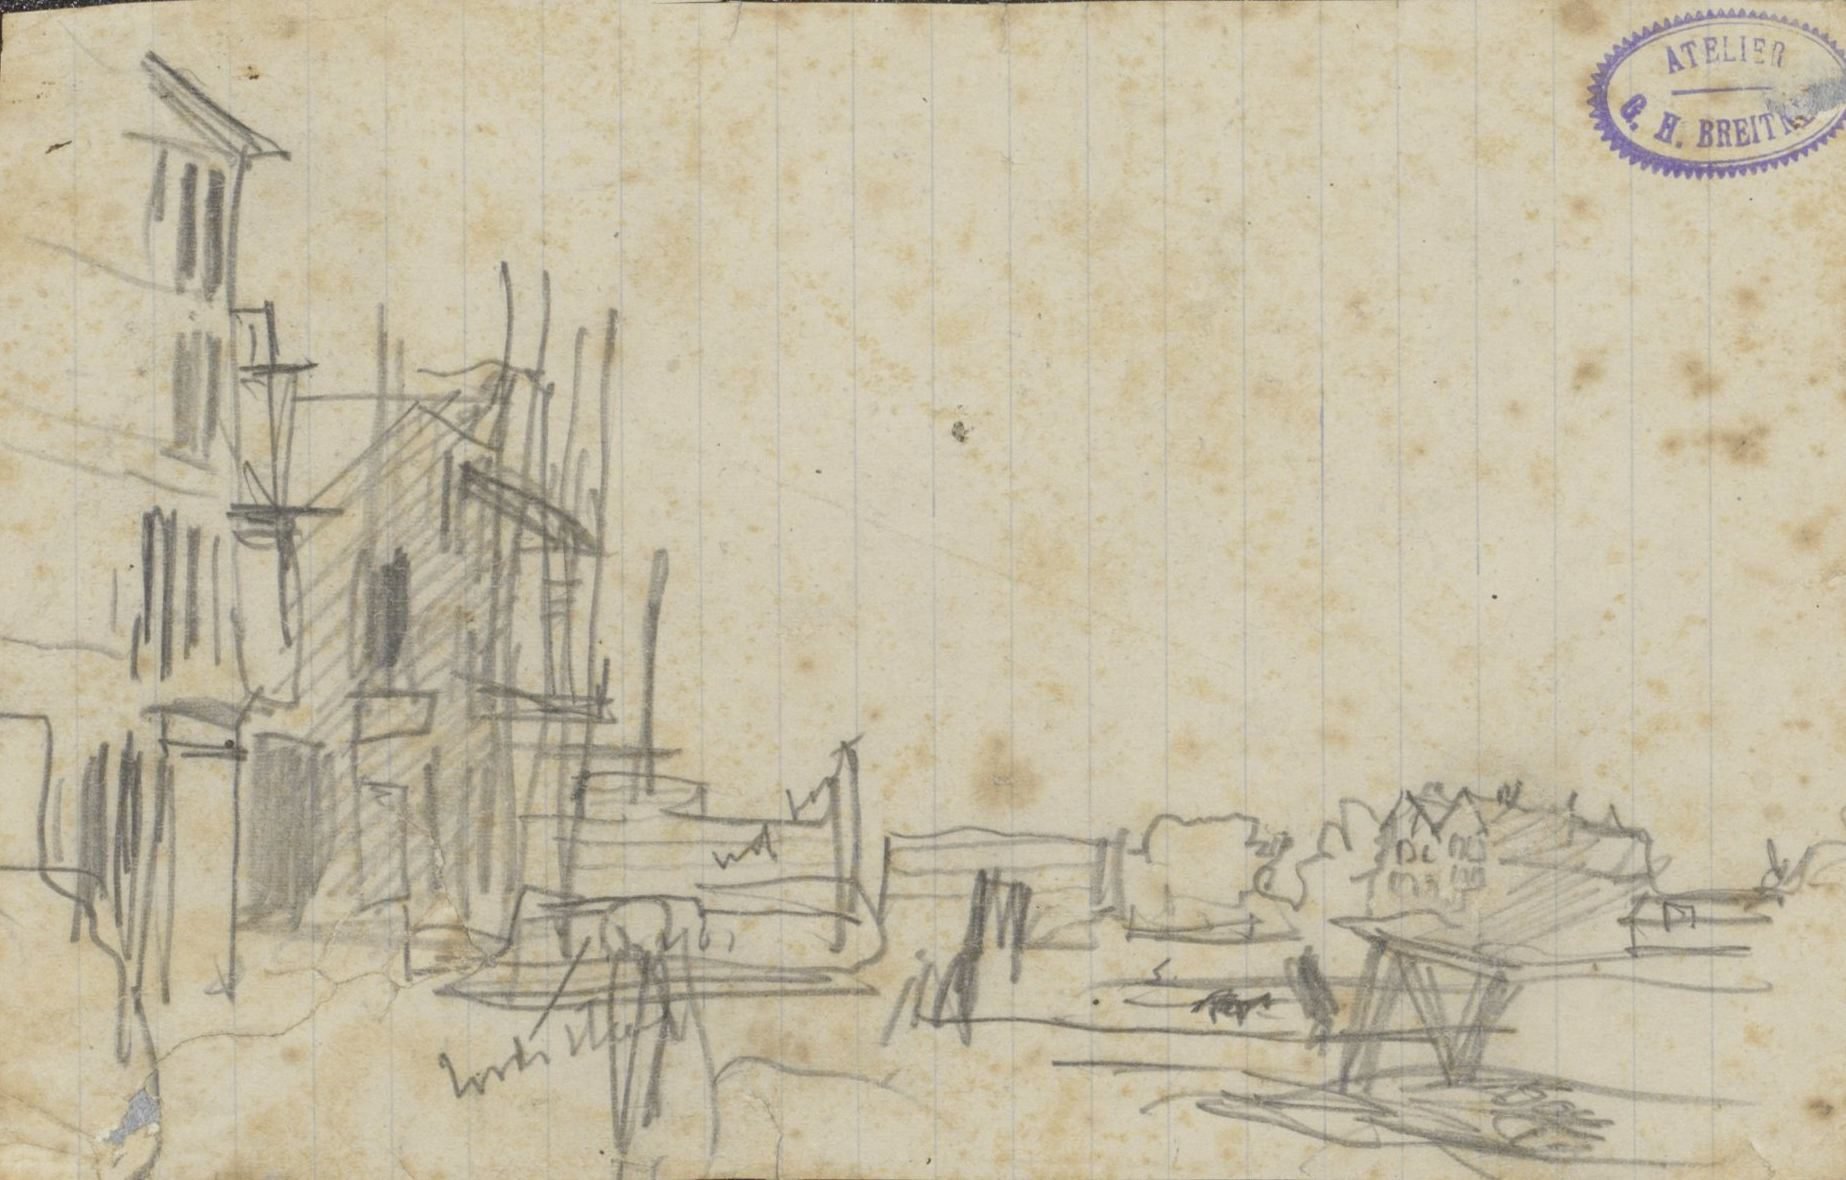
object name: drawing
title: Huizen in aanbouw bij de Jan Pieter Heijestraat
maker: george hendrik breitner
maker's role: draughtsman, painter, print maker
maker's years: 1857-1923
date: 1899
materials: pencil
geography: amsterdam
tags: building-site, civic architecture; edifices; dwellings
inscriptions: workshop stamp: Lugt 291d, annotation: ‘Rokin 95/ R. Weeling’, collector's mark: Lugt 2228